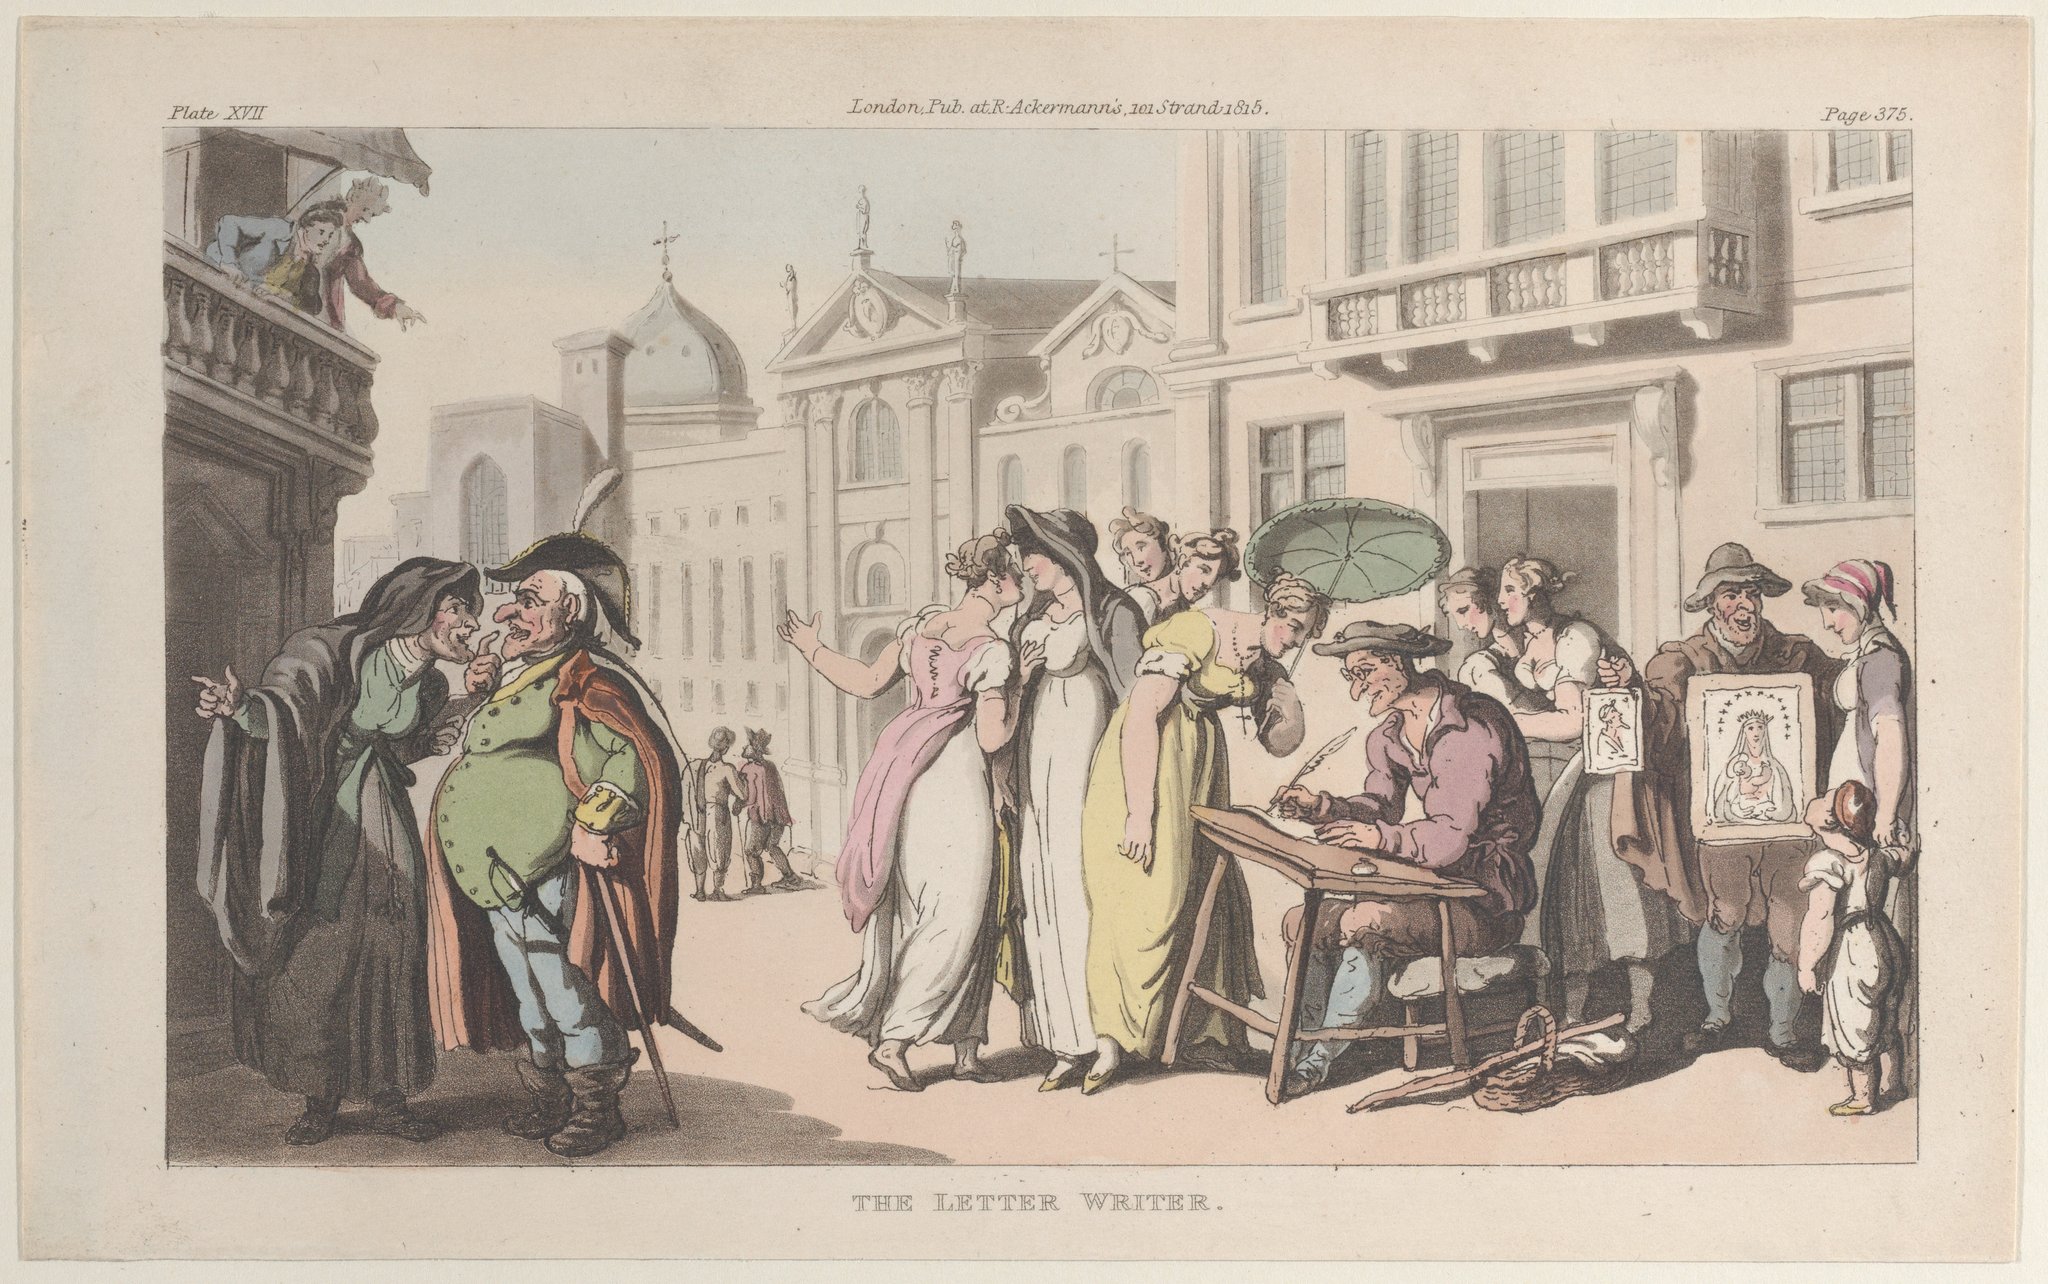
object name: print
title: The Letter Writer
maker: thomas rowlandson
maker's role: artist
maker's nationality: british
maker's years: 1757-1827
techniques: aquatint, etching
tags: men,women,writing